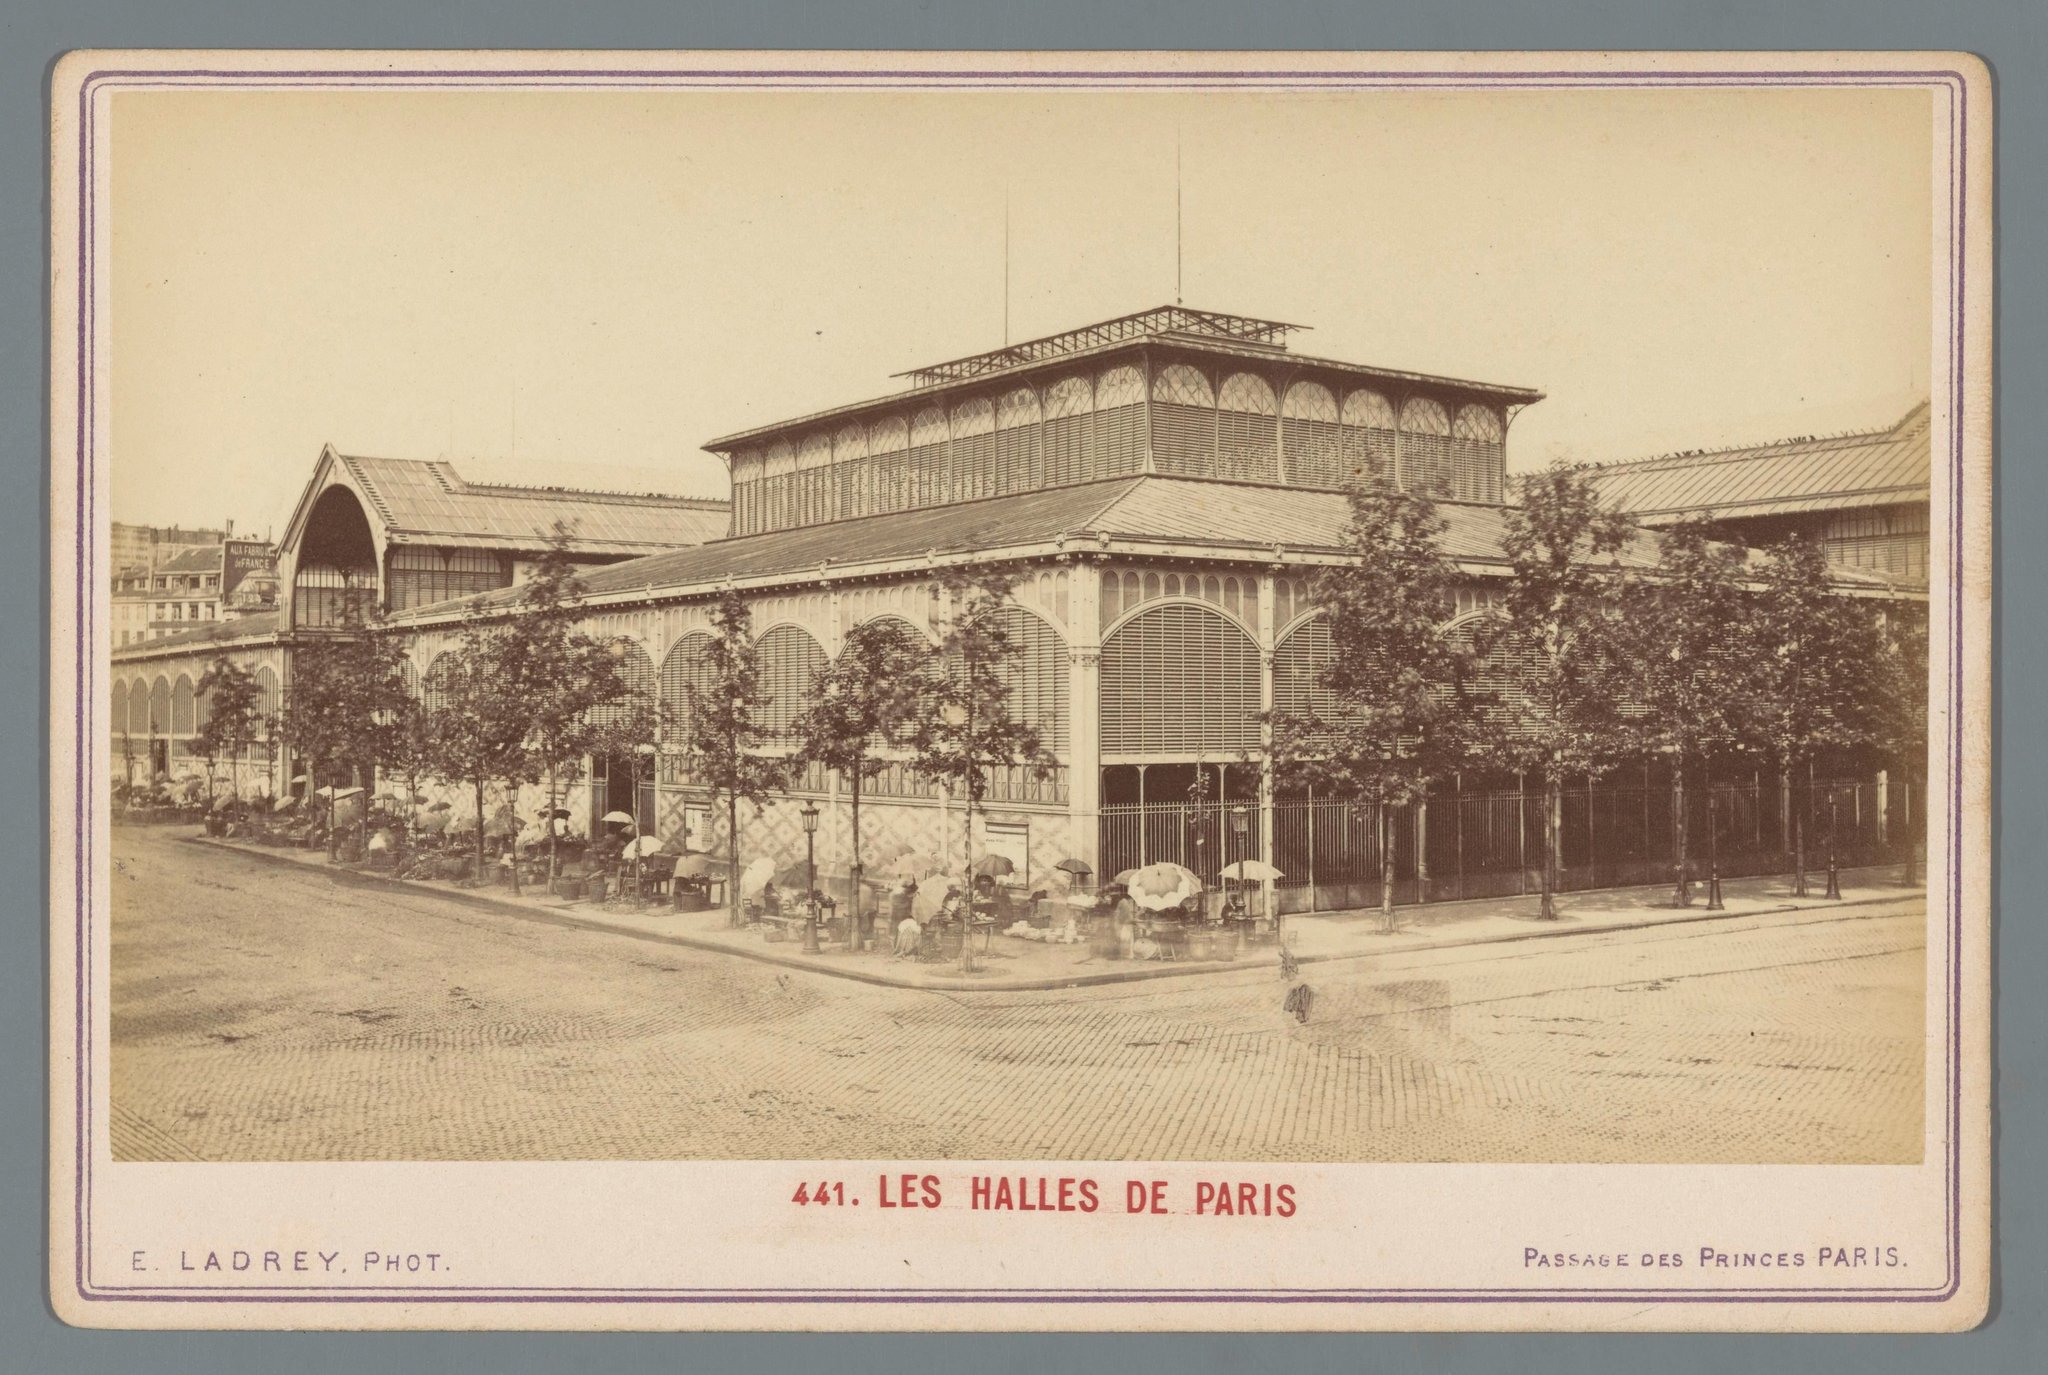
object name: cabinet photograph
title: Les Halles de Paris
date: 1870-1910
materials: cardboard, photographic support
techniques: albumen print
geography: paris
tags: market-hall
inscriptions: number: ‘441.’, inscription: ‘Passage des Princes Paris.’